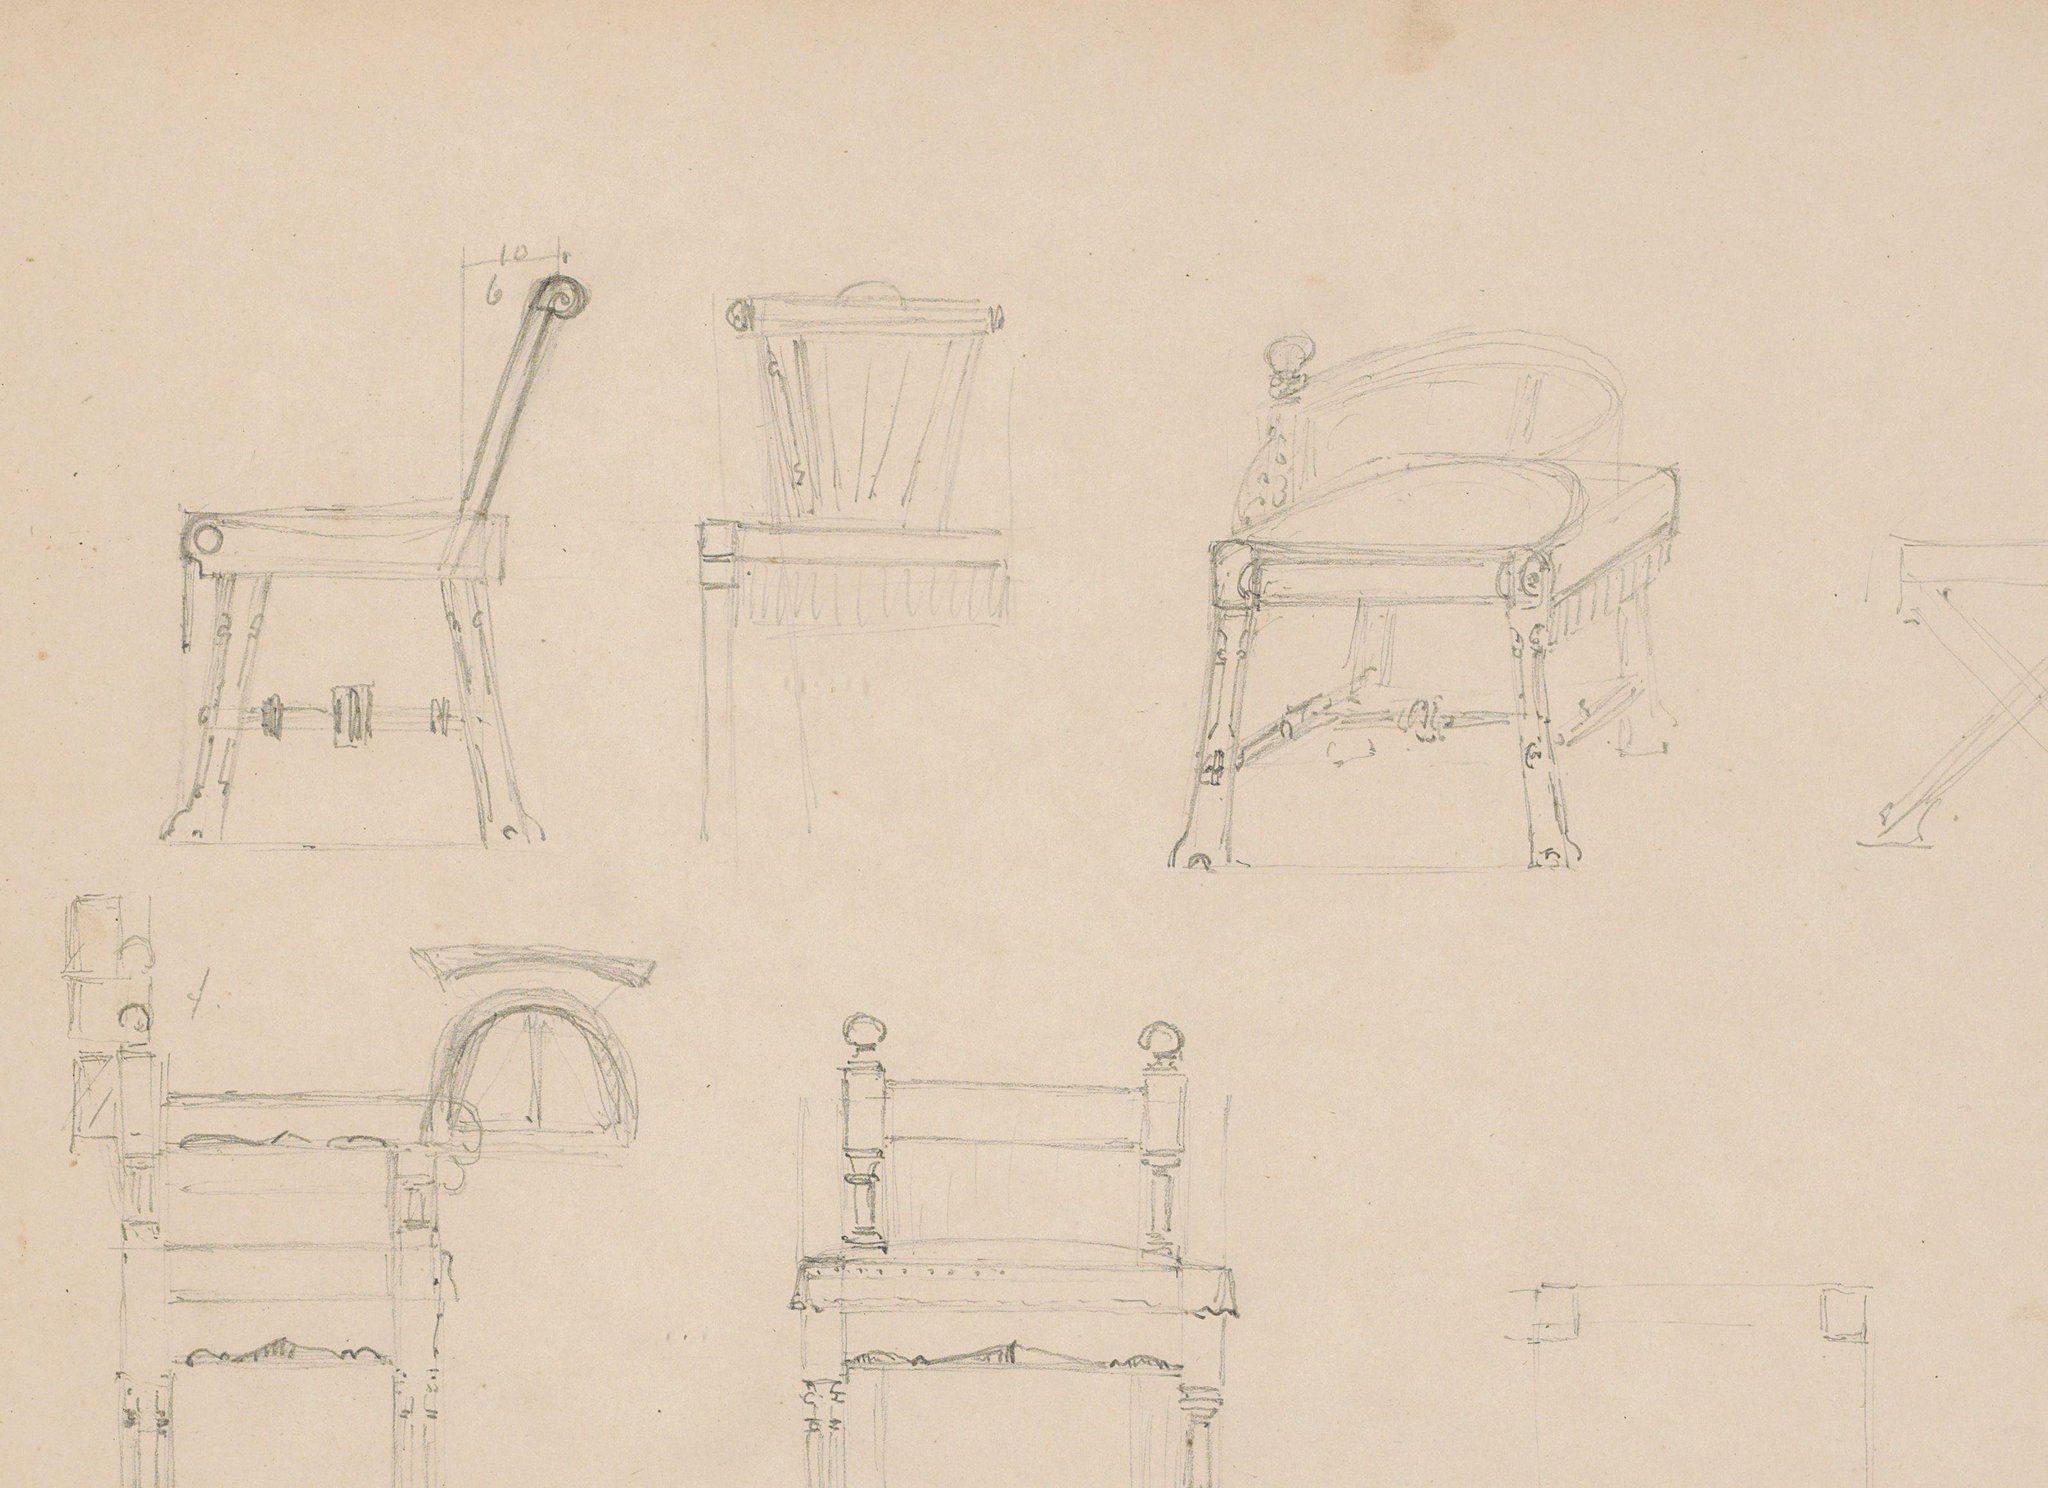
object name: sketchbook leaf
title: Fauteuils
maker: pierre joseph hubert cuypers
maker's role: draughtsman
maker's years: 1827-1921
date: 1857-1859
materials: paper, pencil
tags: armchair, seat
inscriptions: annotation: ‘fauteuils 57?/ v a -6’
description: Blad 36 recto uit een schetsboek met 77 bladen.